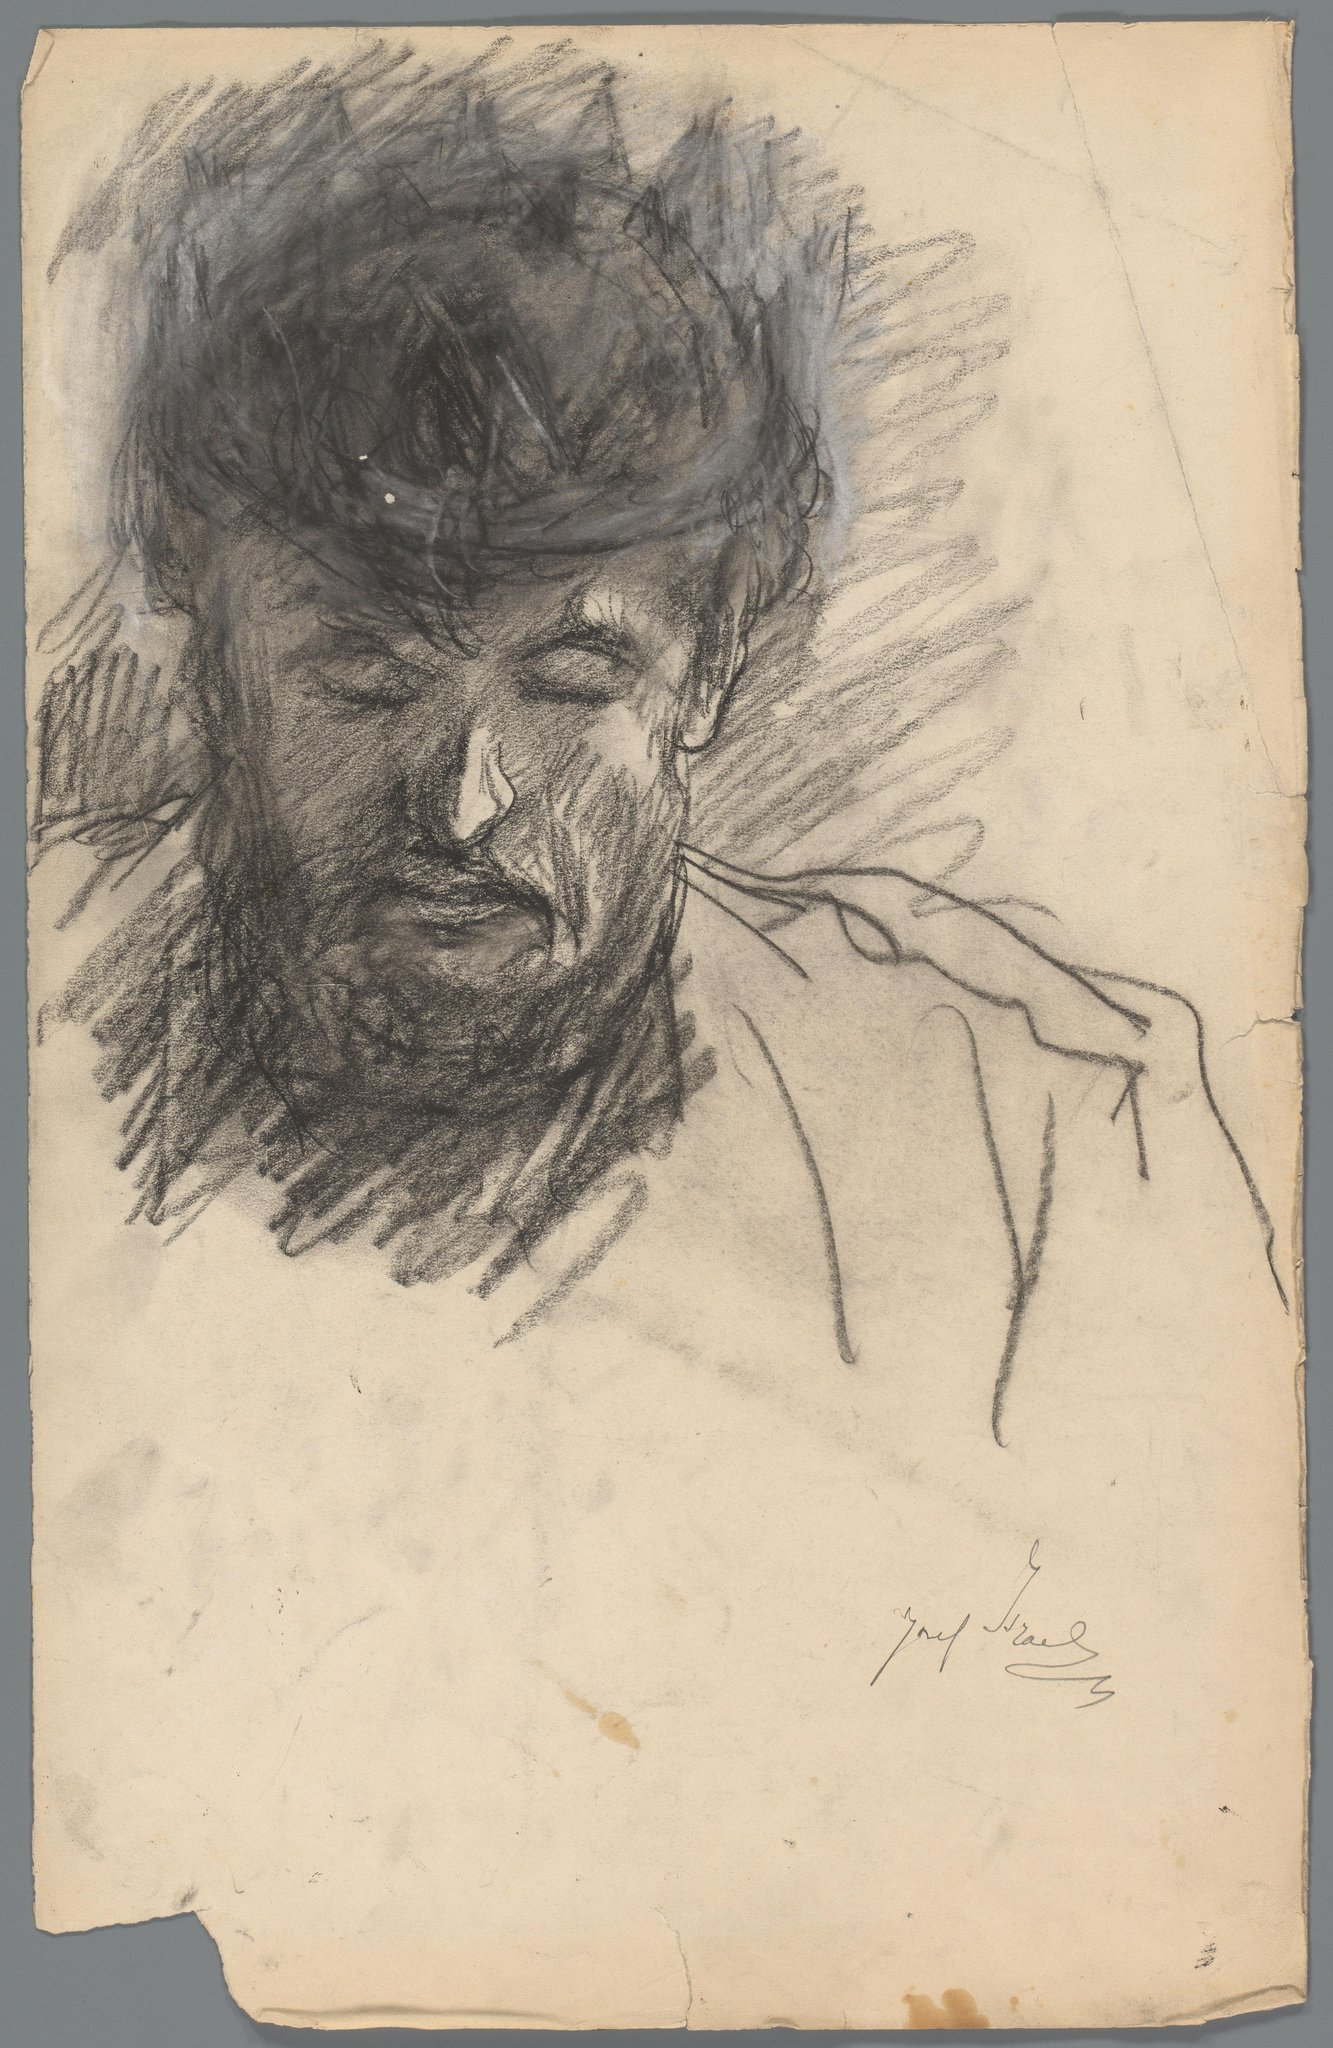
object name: drawing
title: Hoofd van Saul met kroon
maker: jozef israëls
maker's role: draughtsman, painter, print maker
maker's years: 1824-1911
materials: chalk, paper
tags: crown (symbol of sovereignty), head (human), story of saul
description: Voorstudie voor het schilderij 'David en Saul' dat zich in het Groninger Museum bevindt.